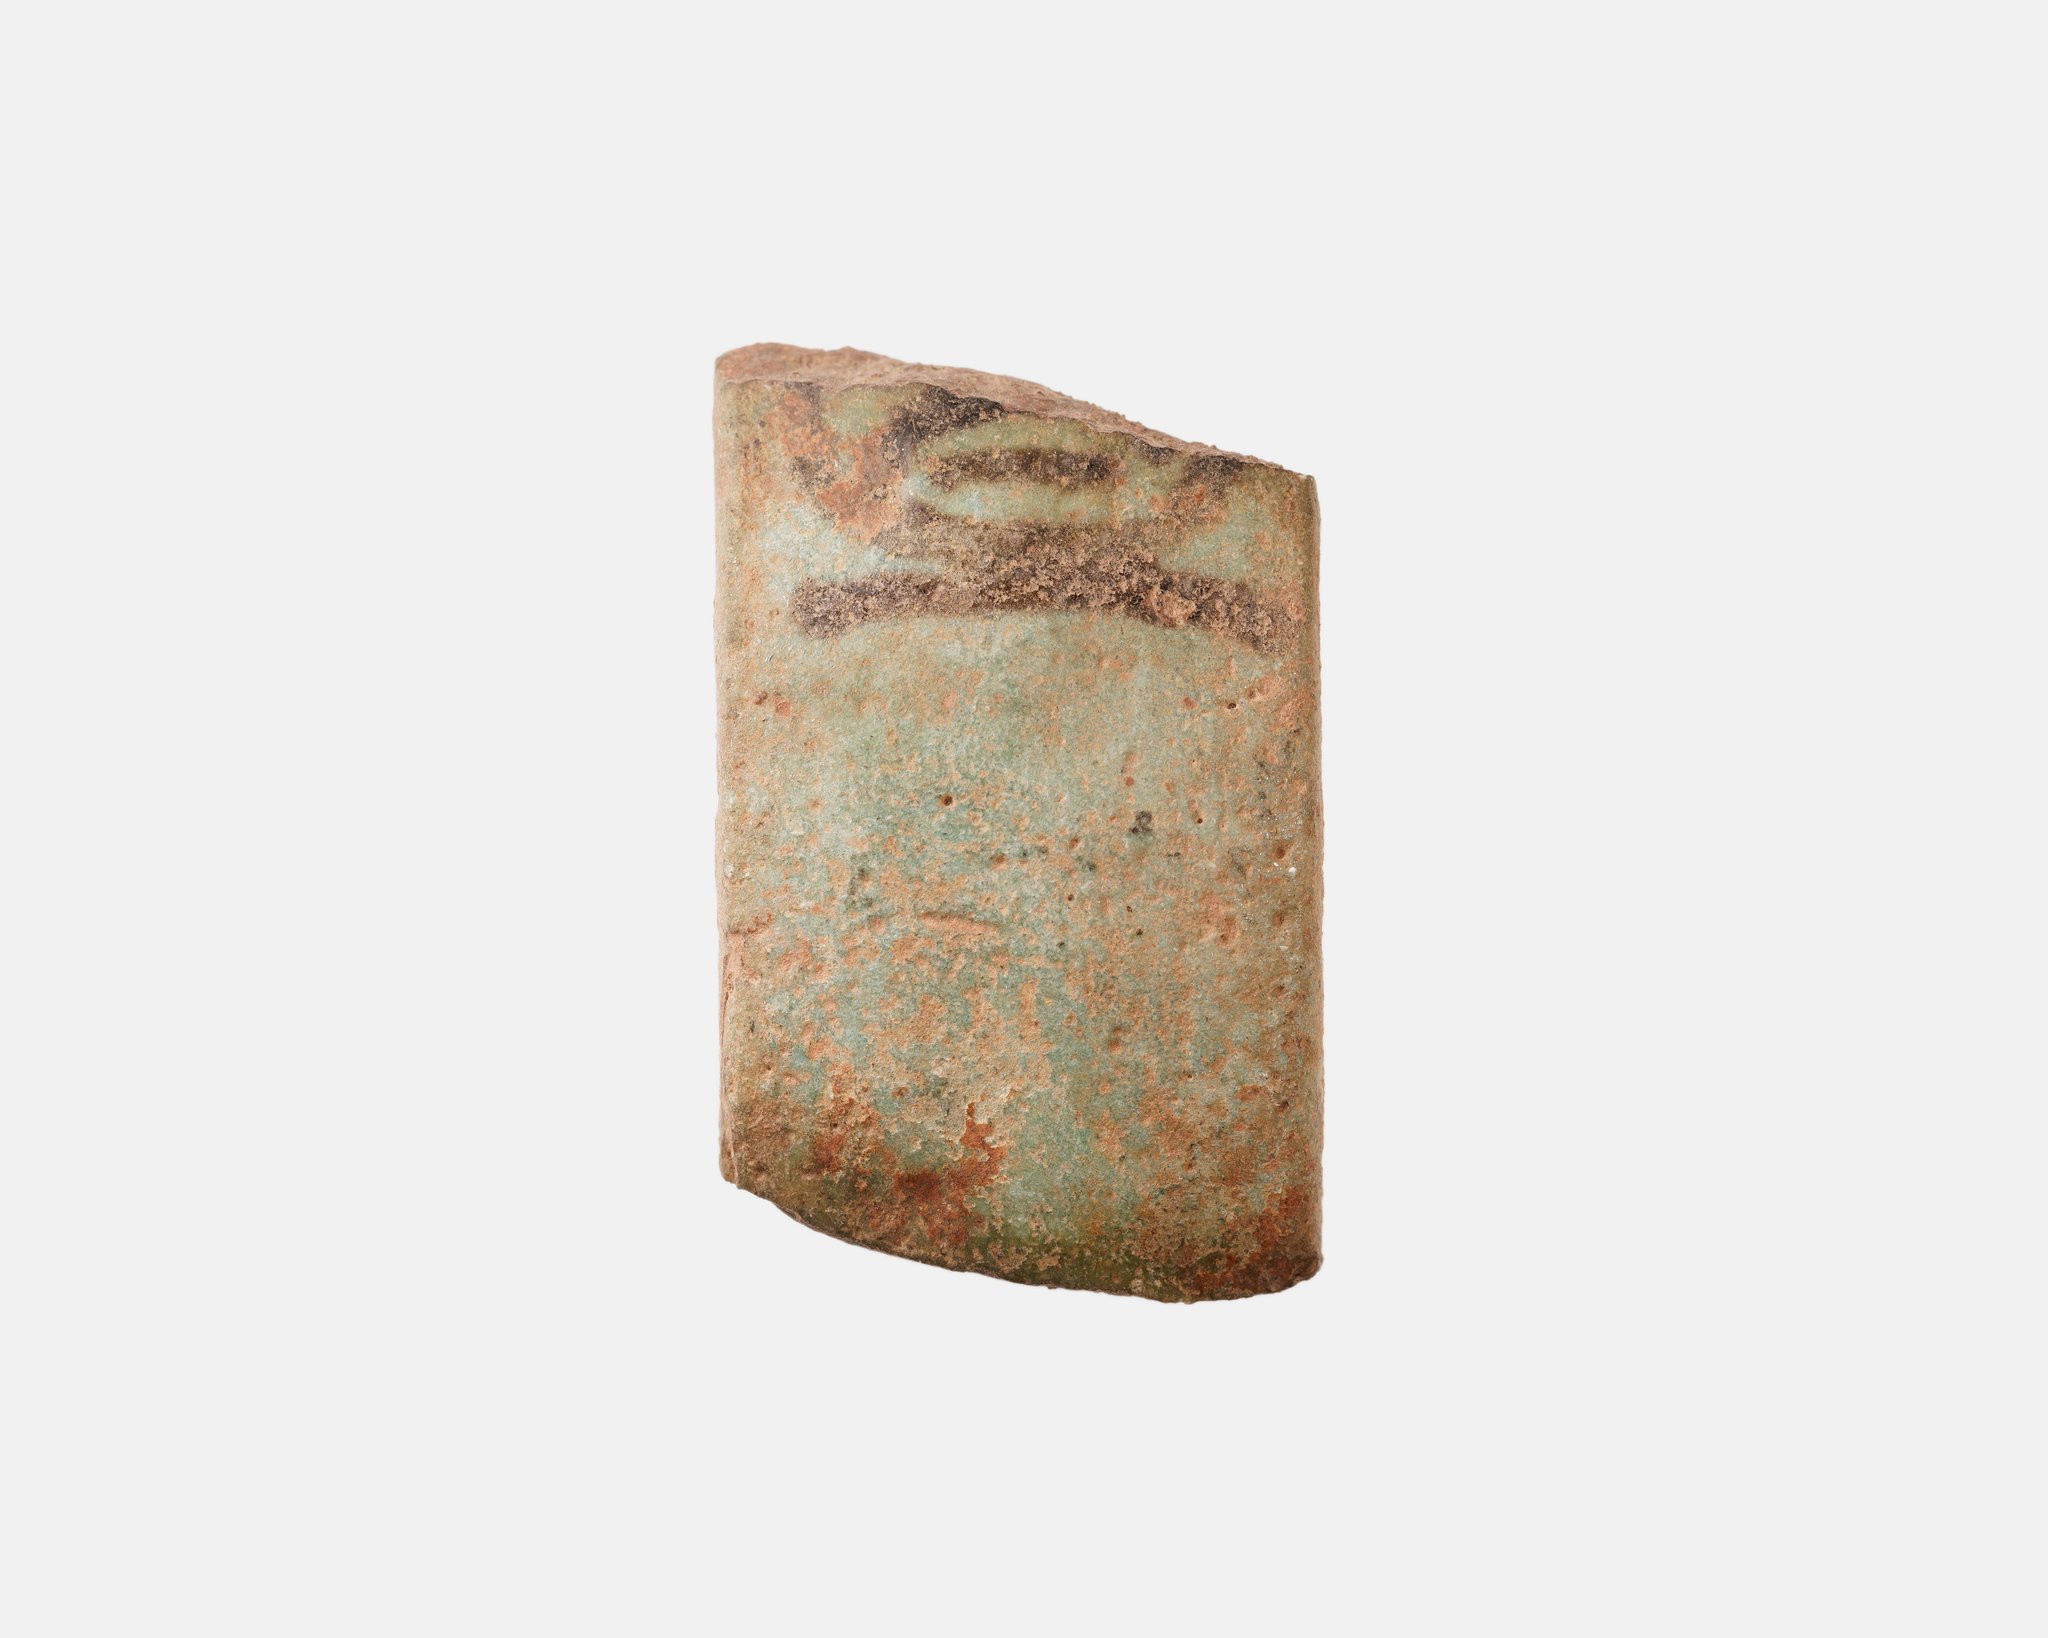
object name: votive bracelet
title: Fragment of a votive bracelet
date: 1295-1070 BCE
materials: faience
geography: egypt